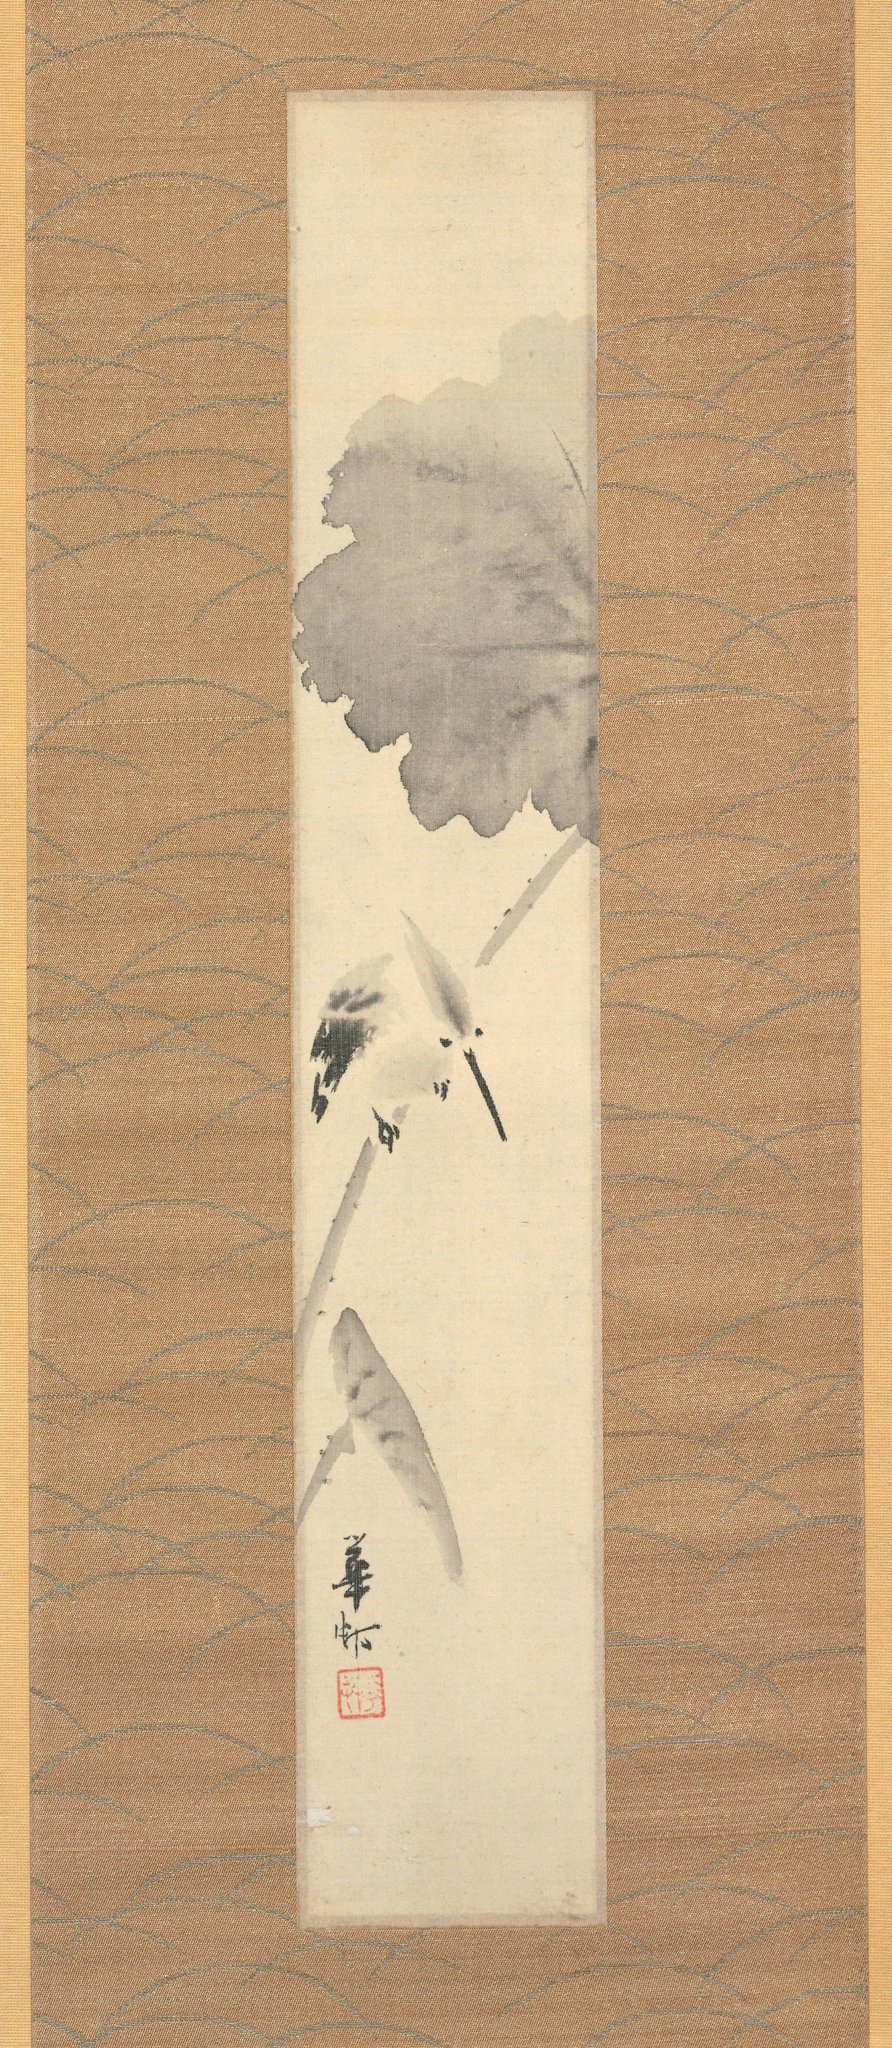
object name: hanging scroll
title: IJsvogel op lotustak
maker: suzuki kason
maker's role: painter, print maker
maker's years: 1860-1919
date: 1880-1919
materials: silk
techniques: brush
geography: japan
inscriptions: signature: ‘Kason’, seal: ‘Koson’, seal: ‘Kason’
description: Een ijsvogel zit op een half vergane lotustak. In houten doos.